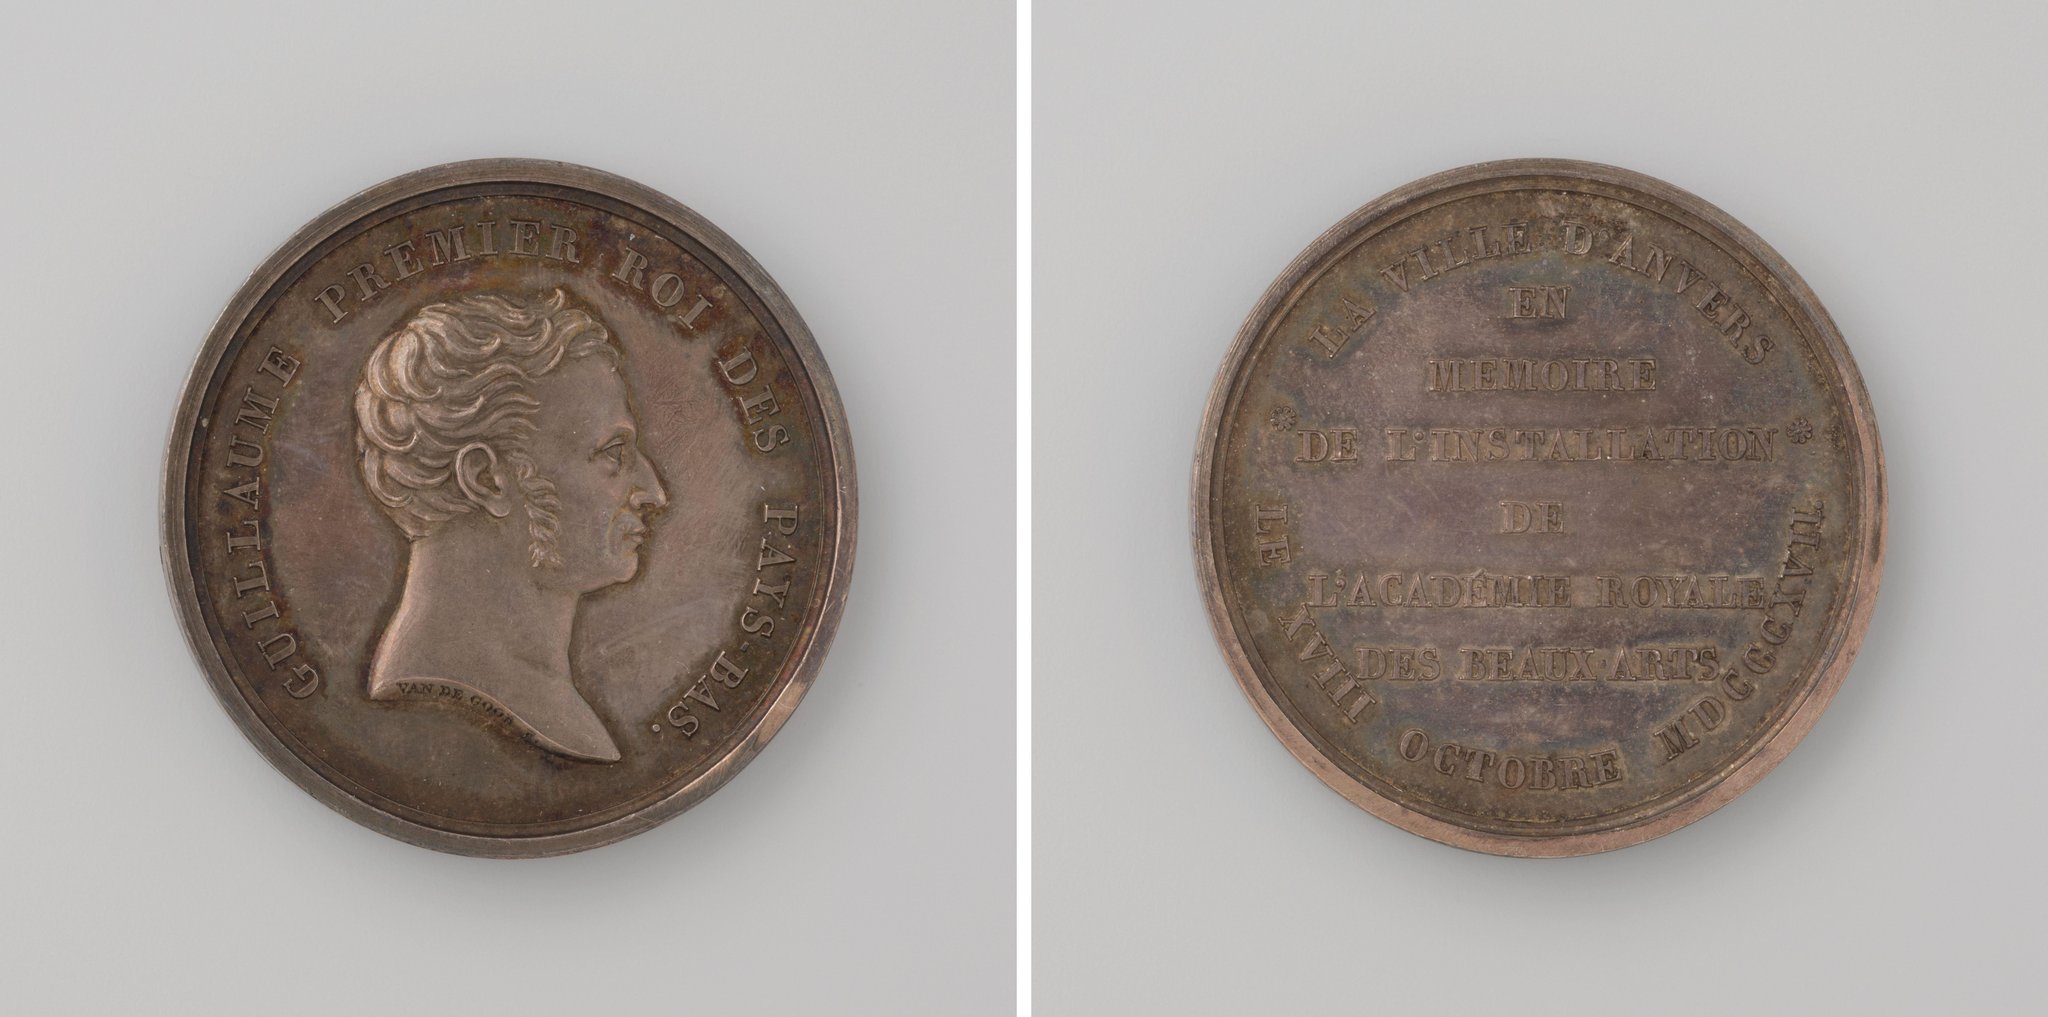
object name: history medal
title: Stichting van de Koninklijke Akademie van Schoone Kunsten te Antwerpen, ter ere van Willem I Frederik, koning der Nederlanden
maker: pierre wautier van de goor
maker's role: medailleur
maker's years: 1783-1851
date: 1817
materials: silver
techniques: striking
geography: brussels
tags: the hague, berlin, william i of the netherlands, antwerp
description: Zilveren penning. Voorzijde: borststuk man binnen omschrift. Keerzijde: opschrift binnen omschrift